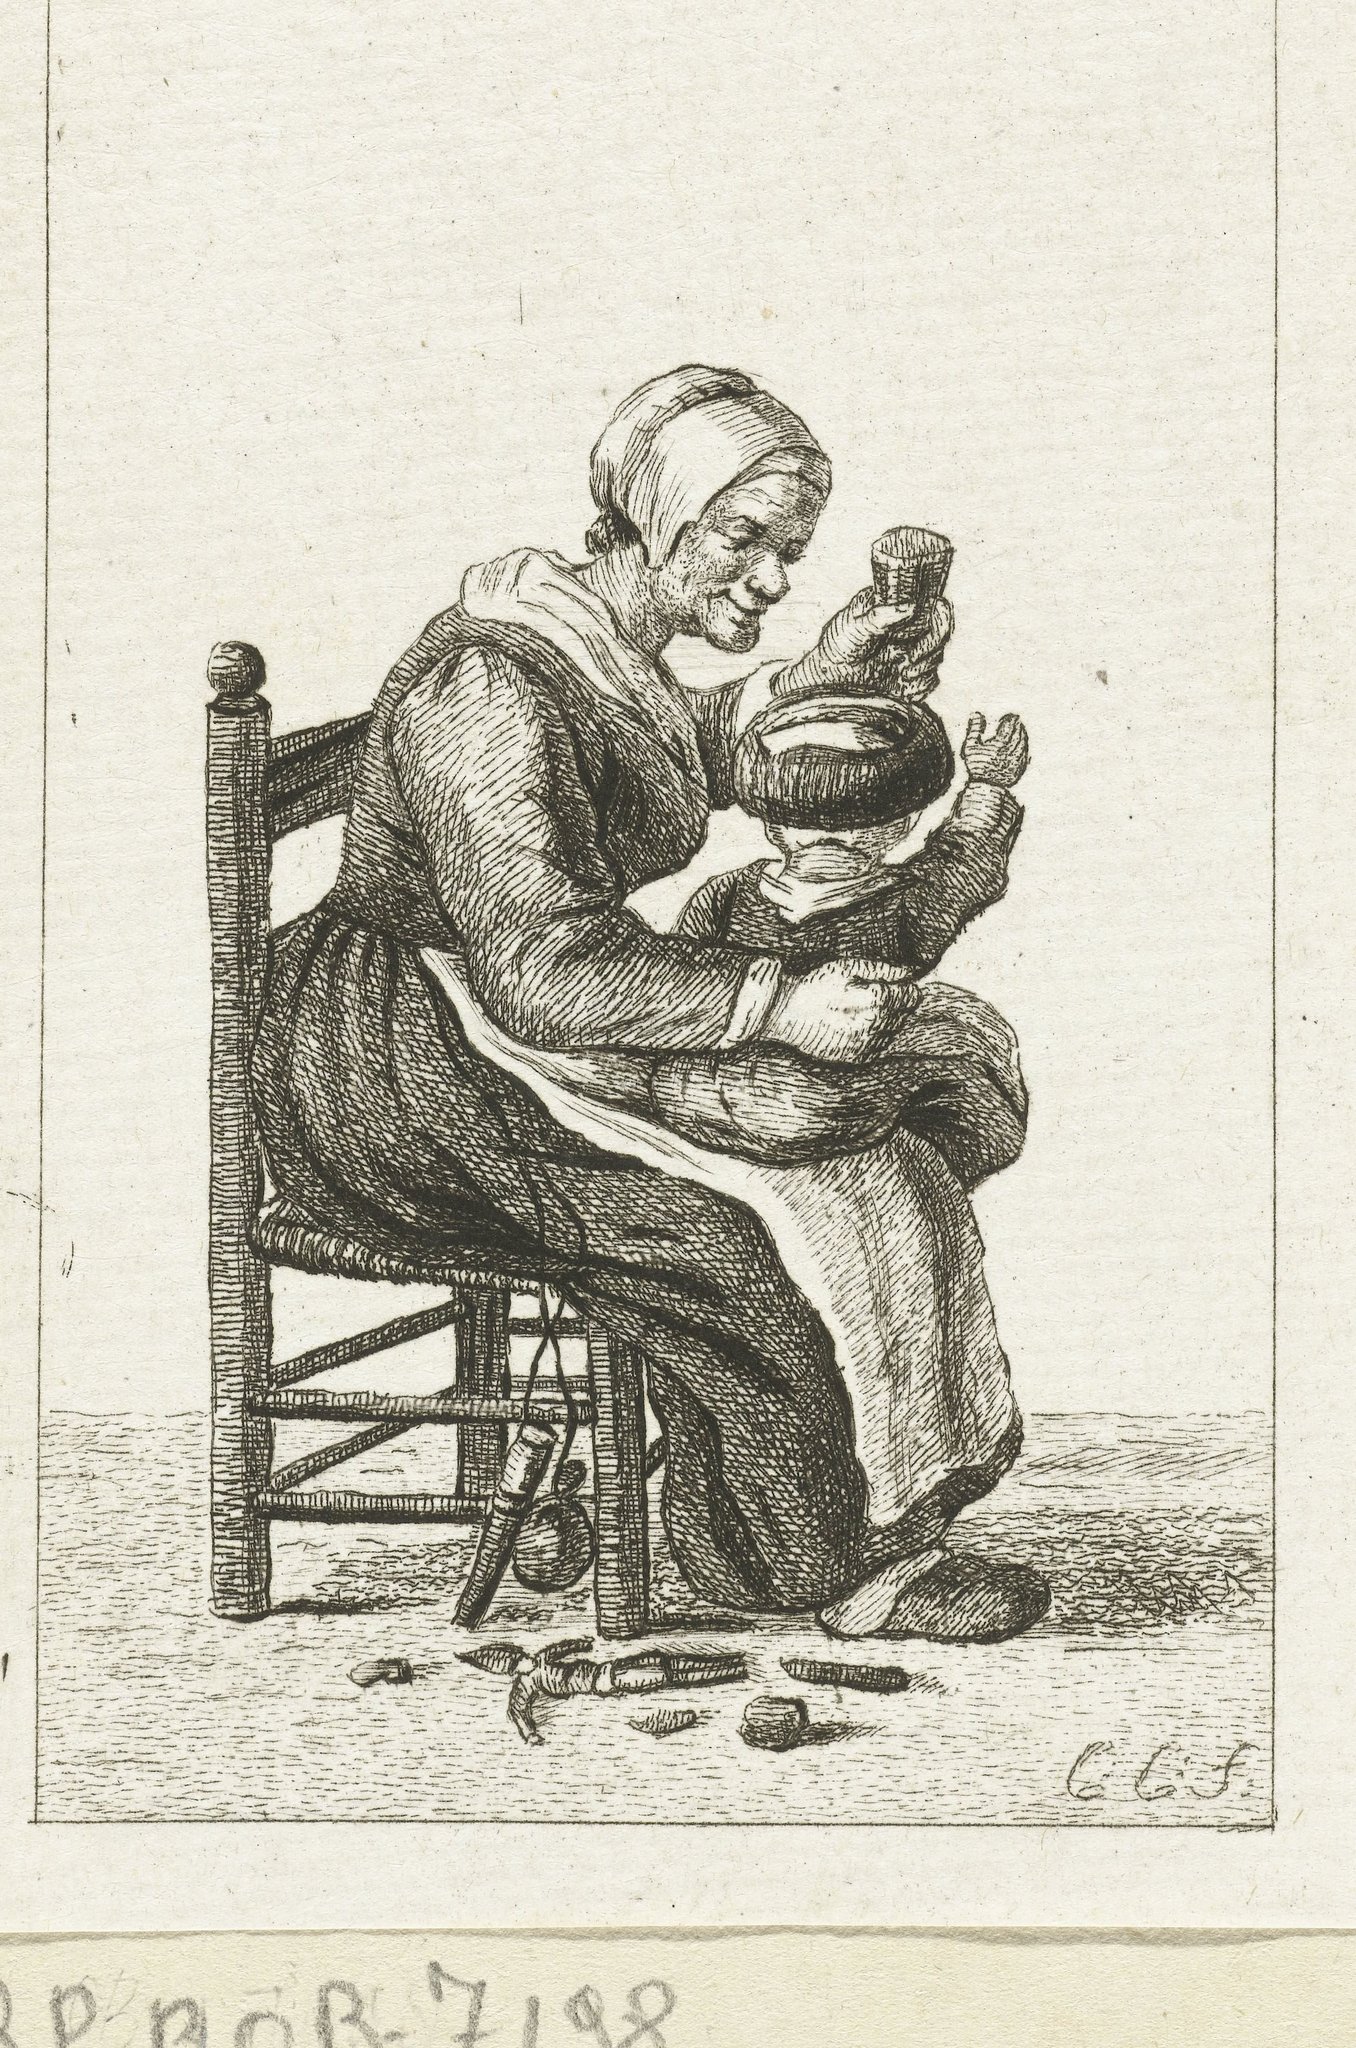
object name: print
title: Vrouw met kind op schoot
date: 1779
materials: paper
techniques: etching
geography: leiden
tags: (playing with) toys, drinking, mother and child(ren), woman and child(ren) (family group) (with number of children)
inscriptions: collector's mark: Lugt 2228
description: Moeder met kind op de schoot. Ze probeert het kind uit een beker te laten drinken. Op de grond wat speelgoed. Profiel naar rechts.